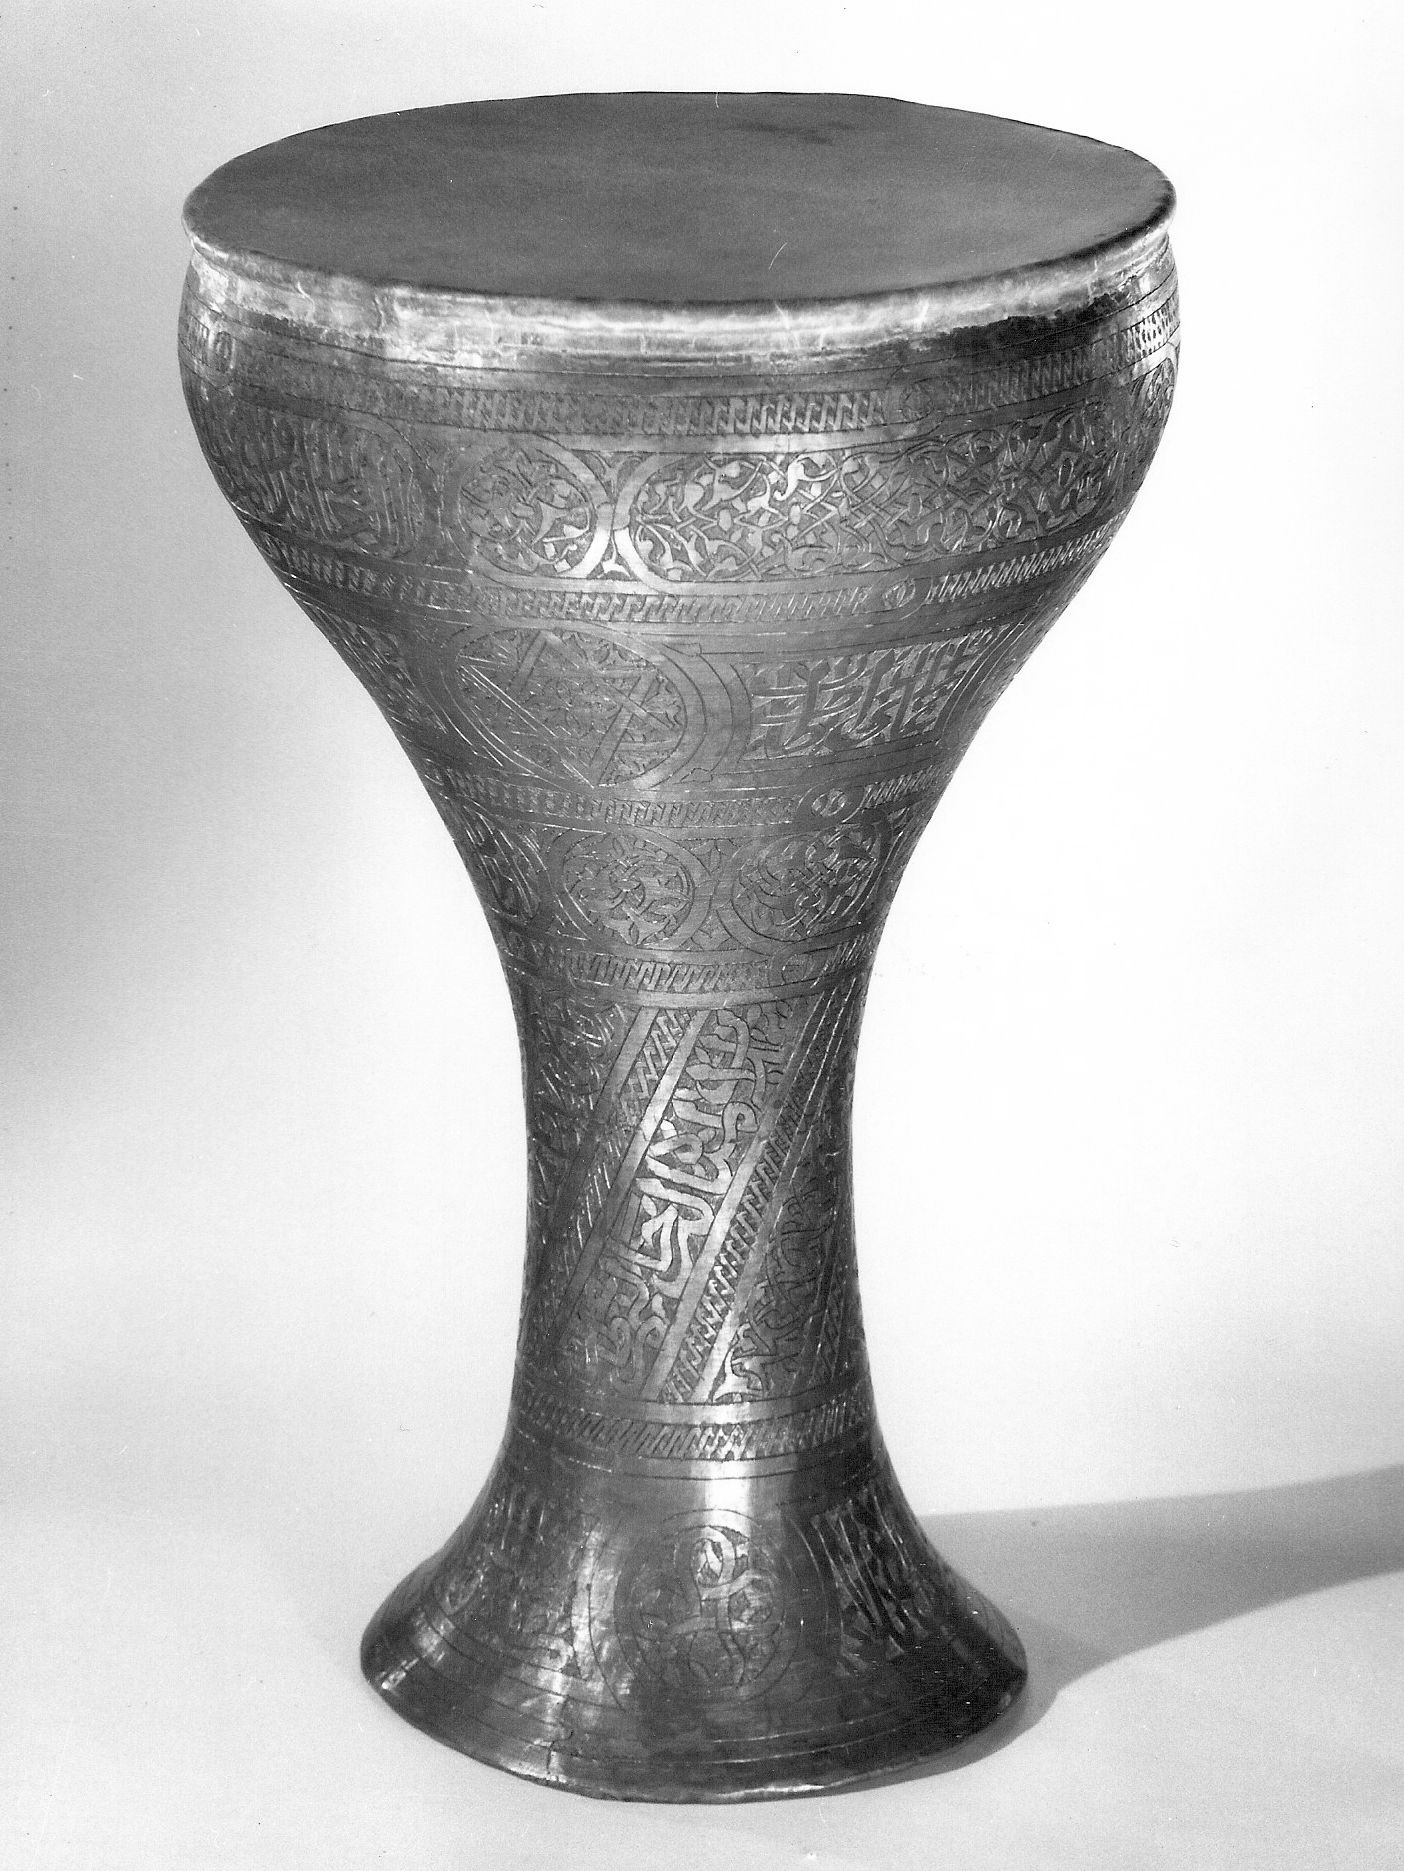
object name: darabukka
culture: algerian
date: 1801-1900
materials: brass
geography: algeria